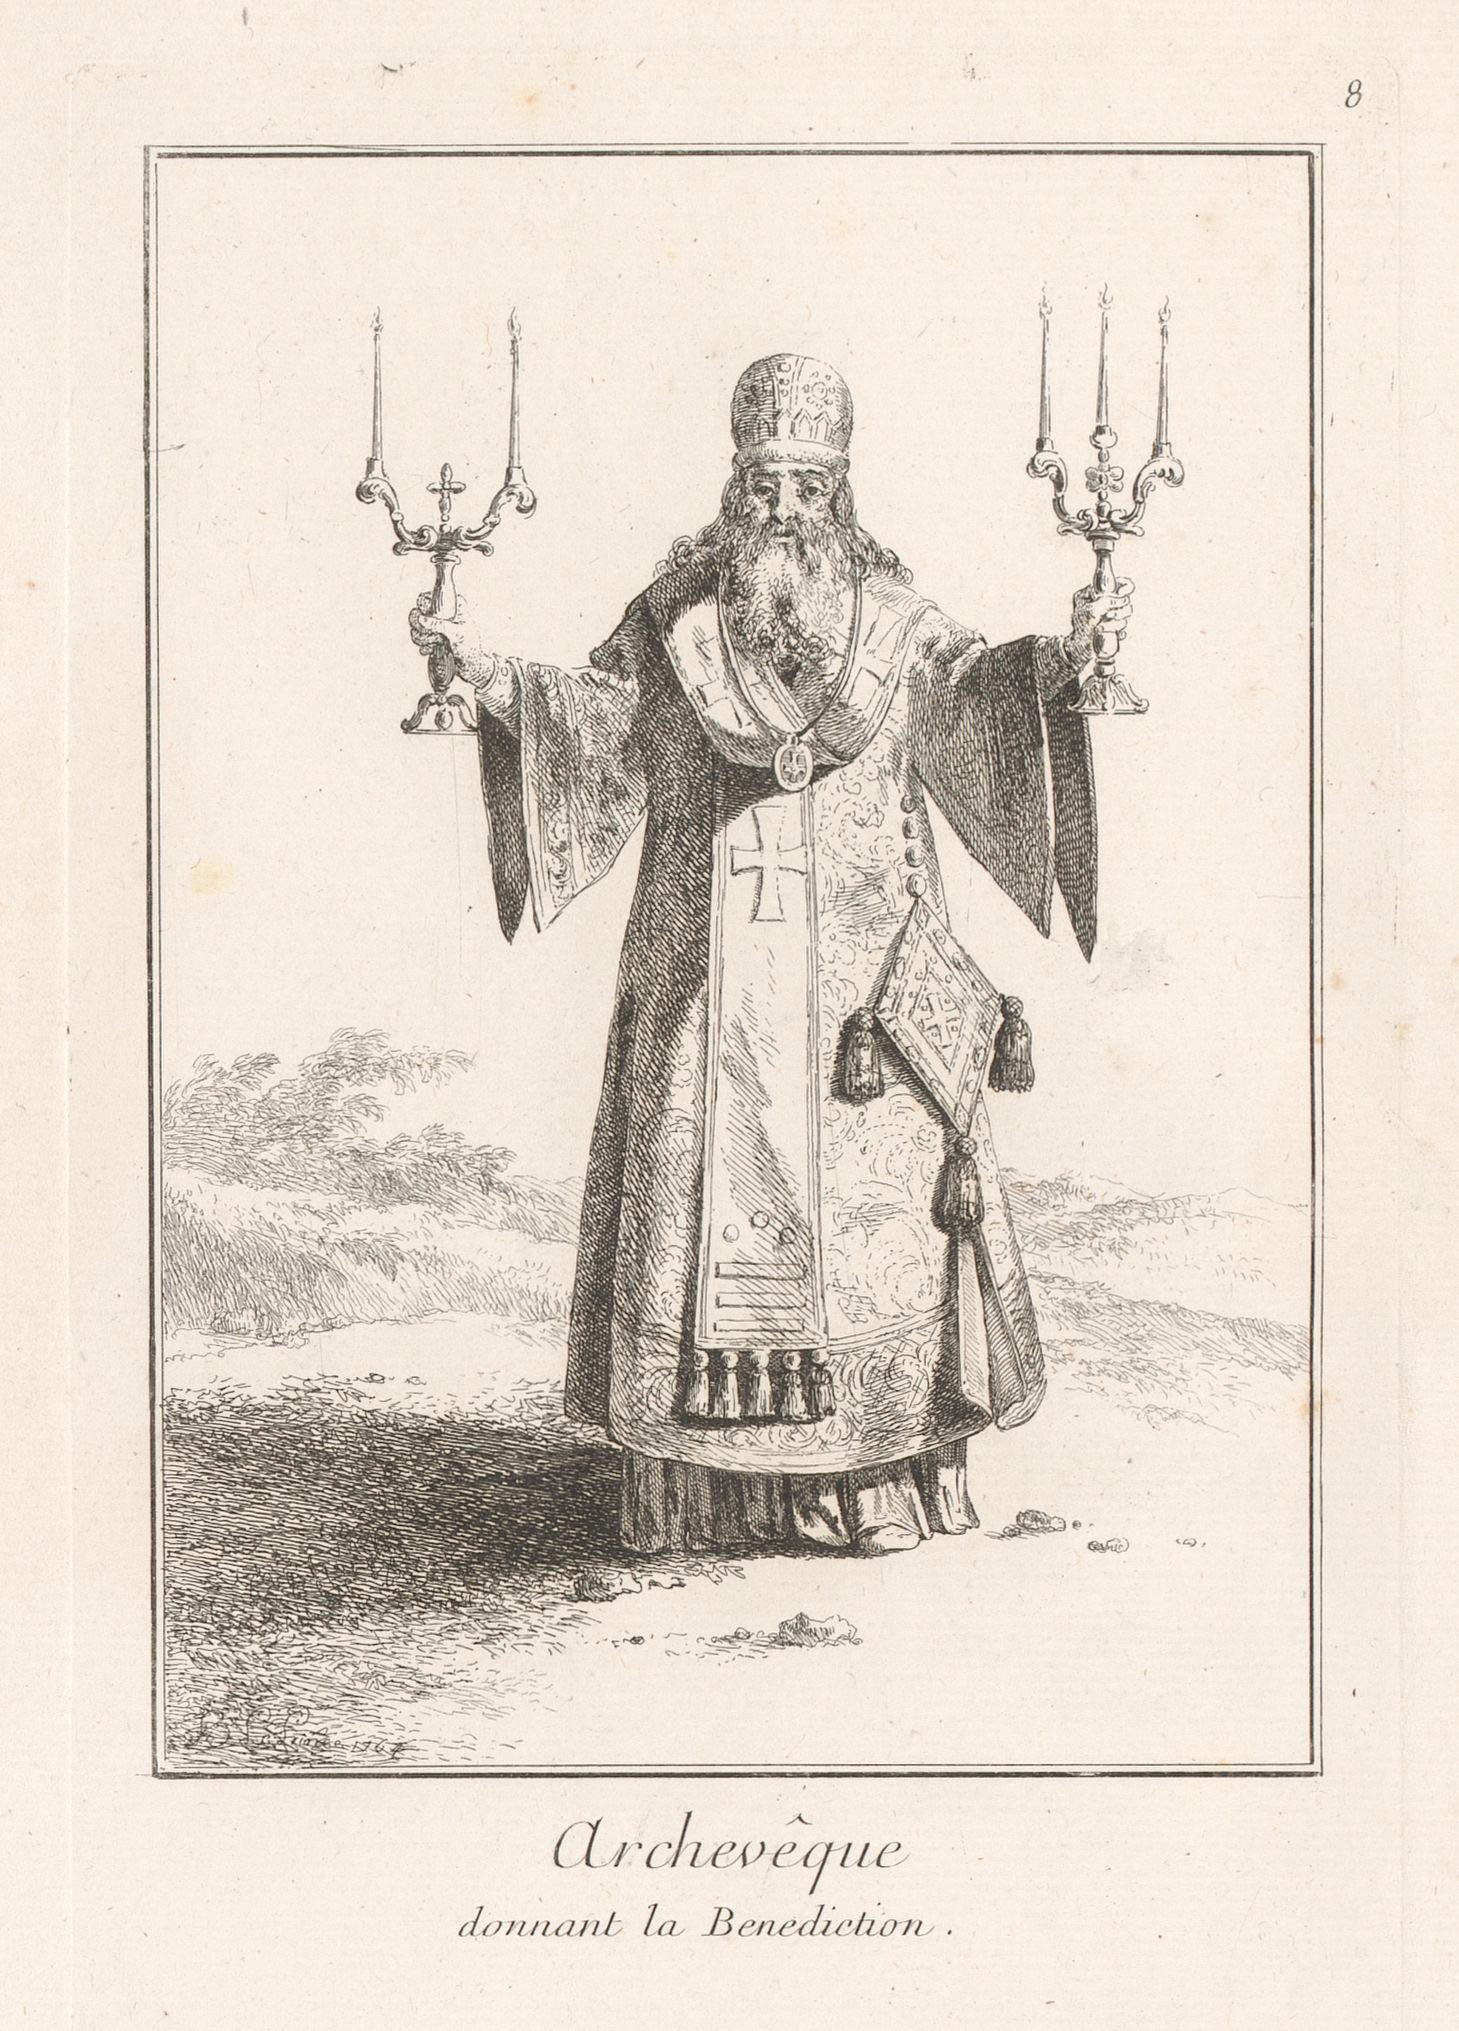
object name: print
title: Diverse klederdrachten van Russische geestelijken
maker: jean baptist leprince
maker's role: draughtsman, print maker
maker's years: 1734-1781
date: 1764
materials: paper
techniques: etching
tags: russian orthodox church, archbishop, bishop, etc. (roman catholic)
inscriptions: date